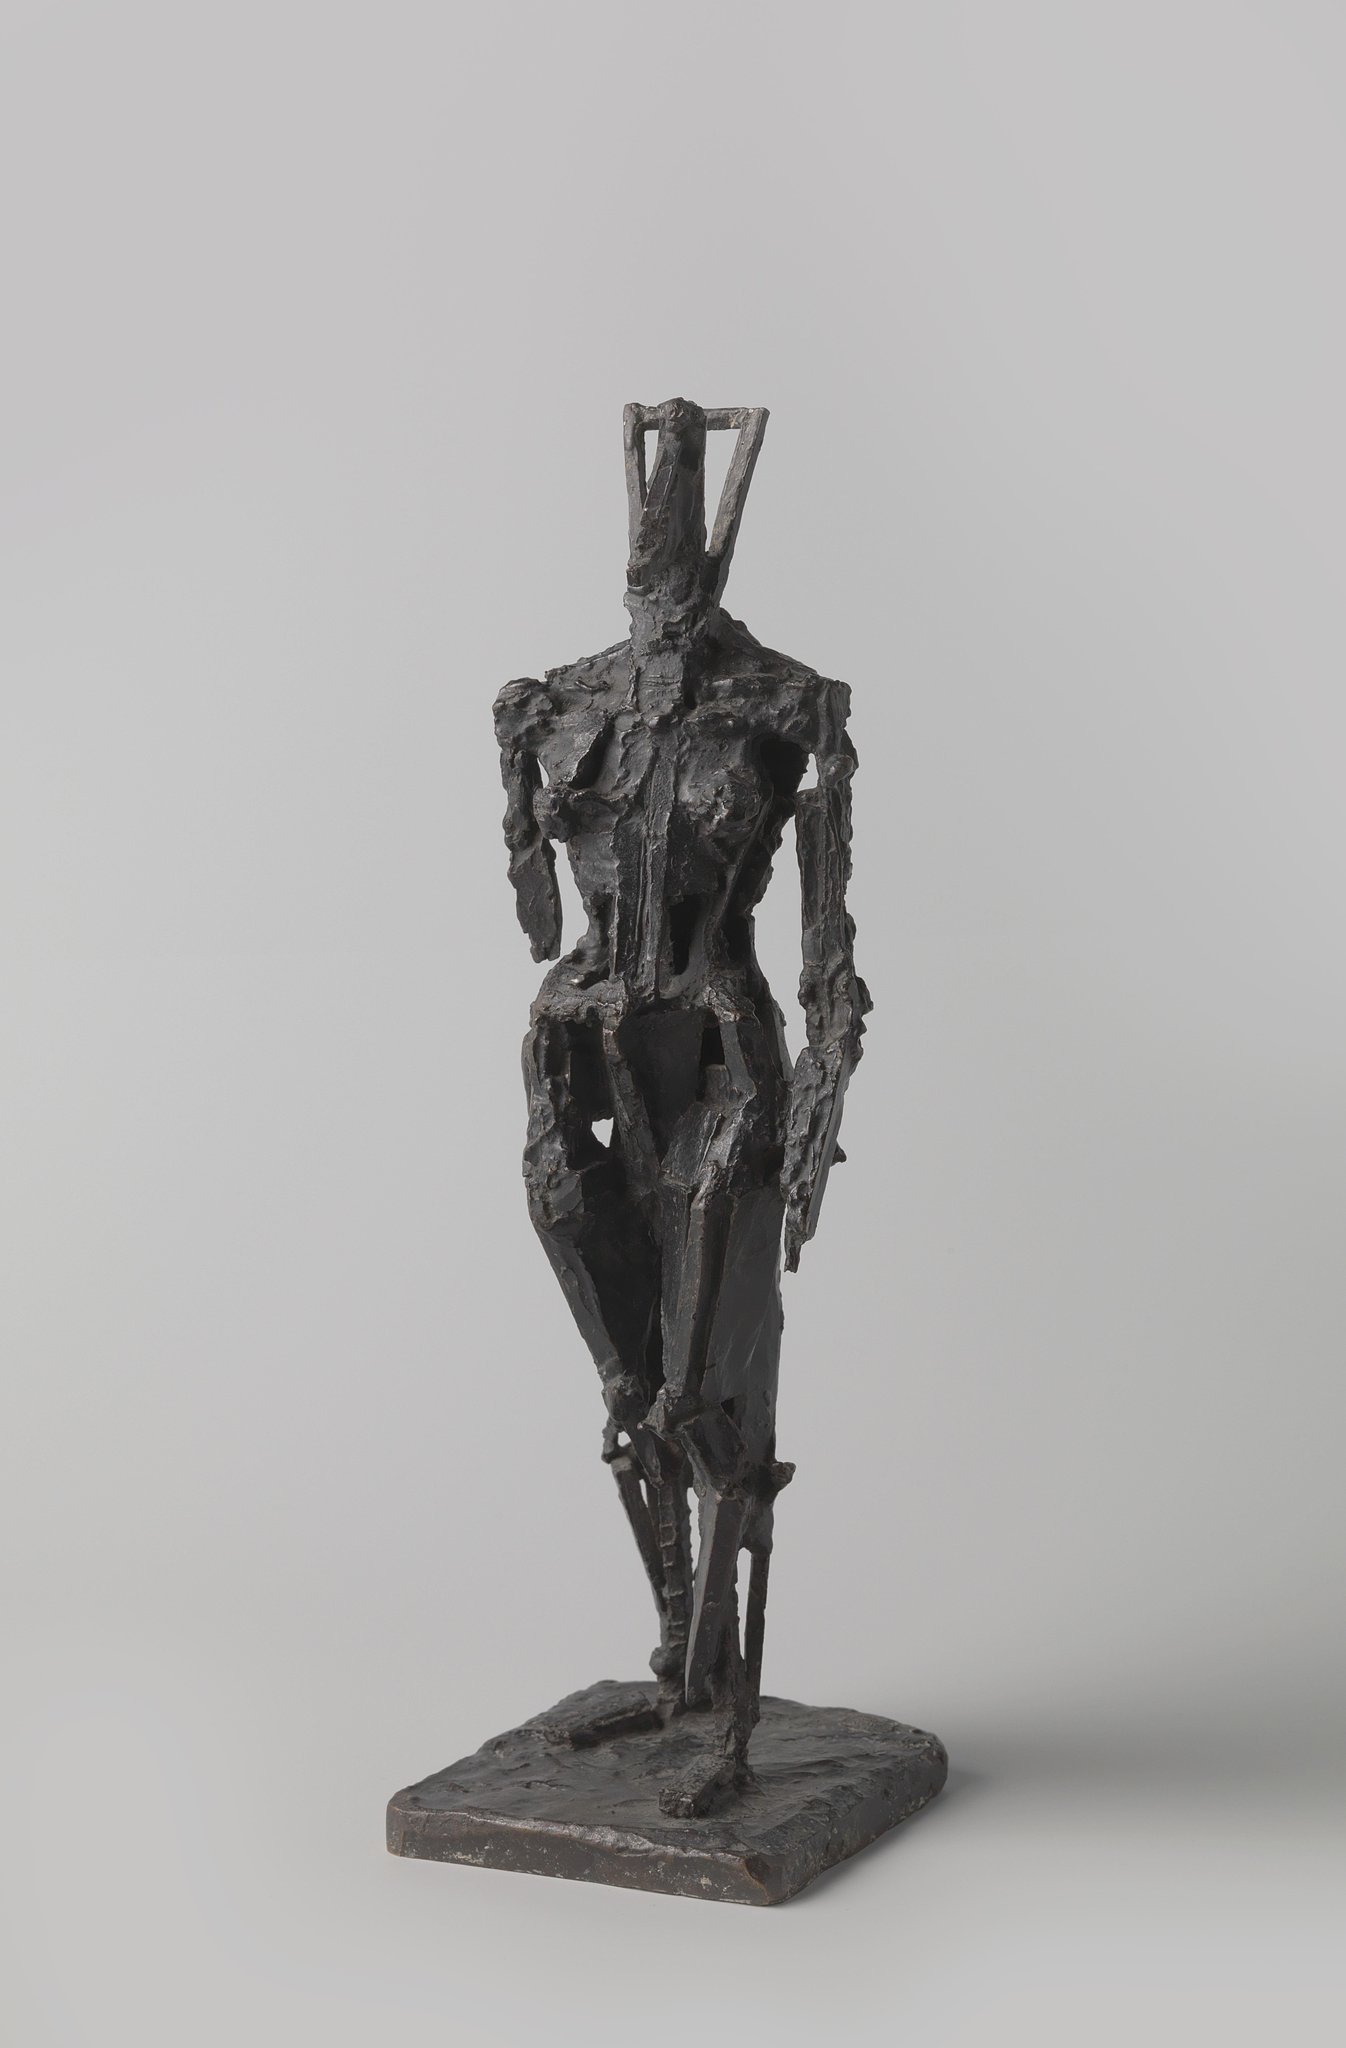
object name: sculpture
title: Constructie van staande vrouwenfiguur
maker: charlotte van pallandt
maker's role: draughtsman, print maker, sculptor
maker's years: 1898-1997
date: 1939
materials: bronze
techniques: casting, lost wax process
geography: netherlands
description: Constructie van een staande vrouwenfiguur. Het beeld heeft een gietersmerk: Valsuani cire perdue.